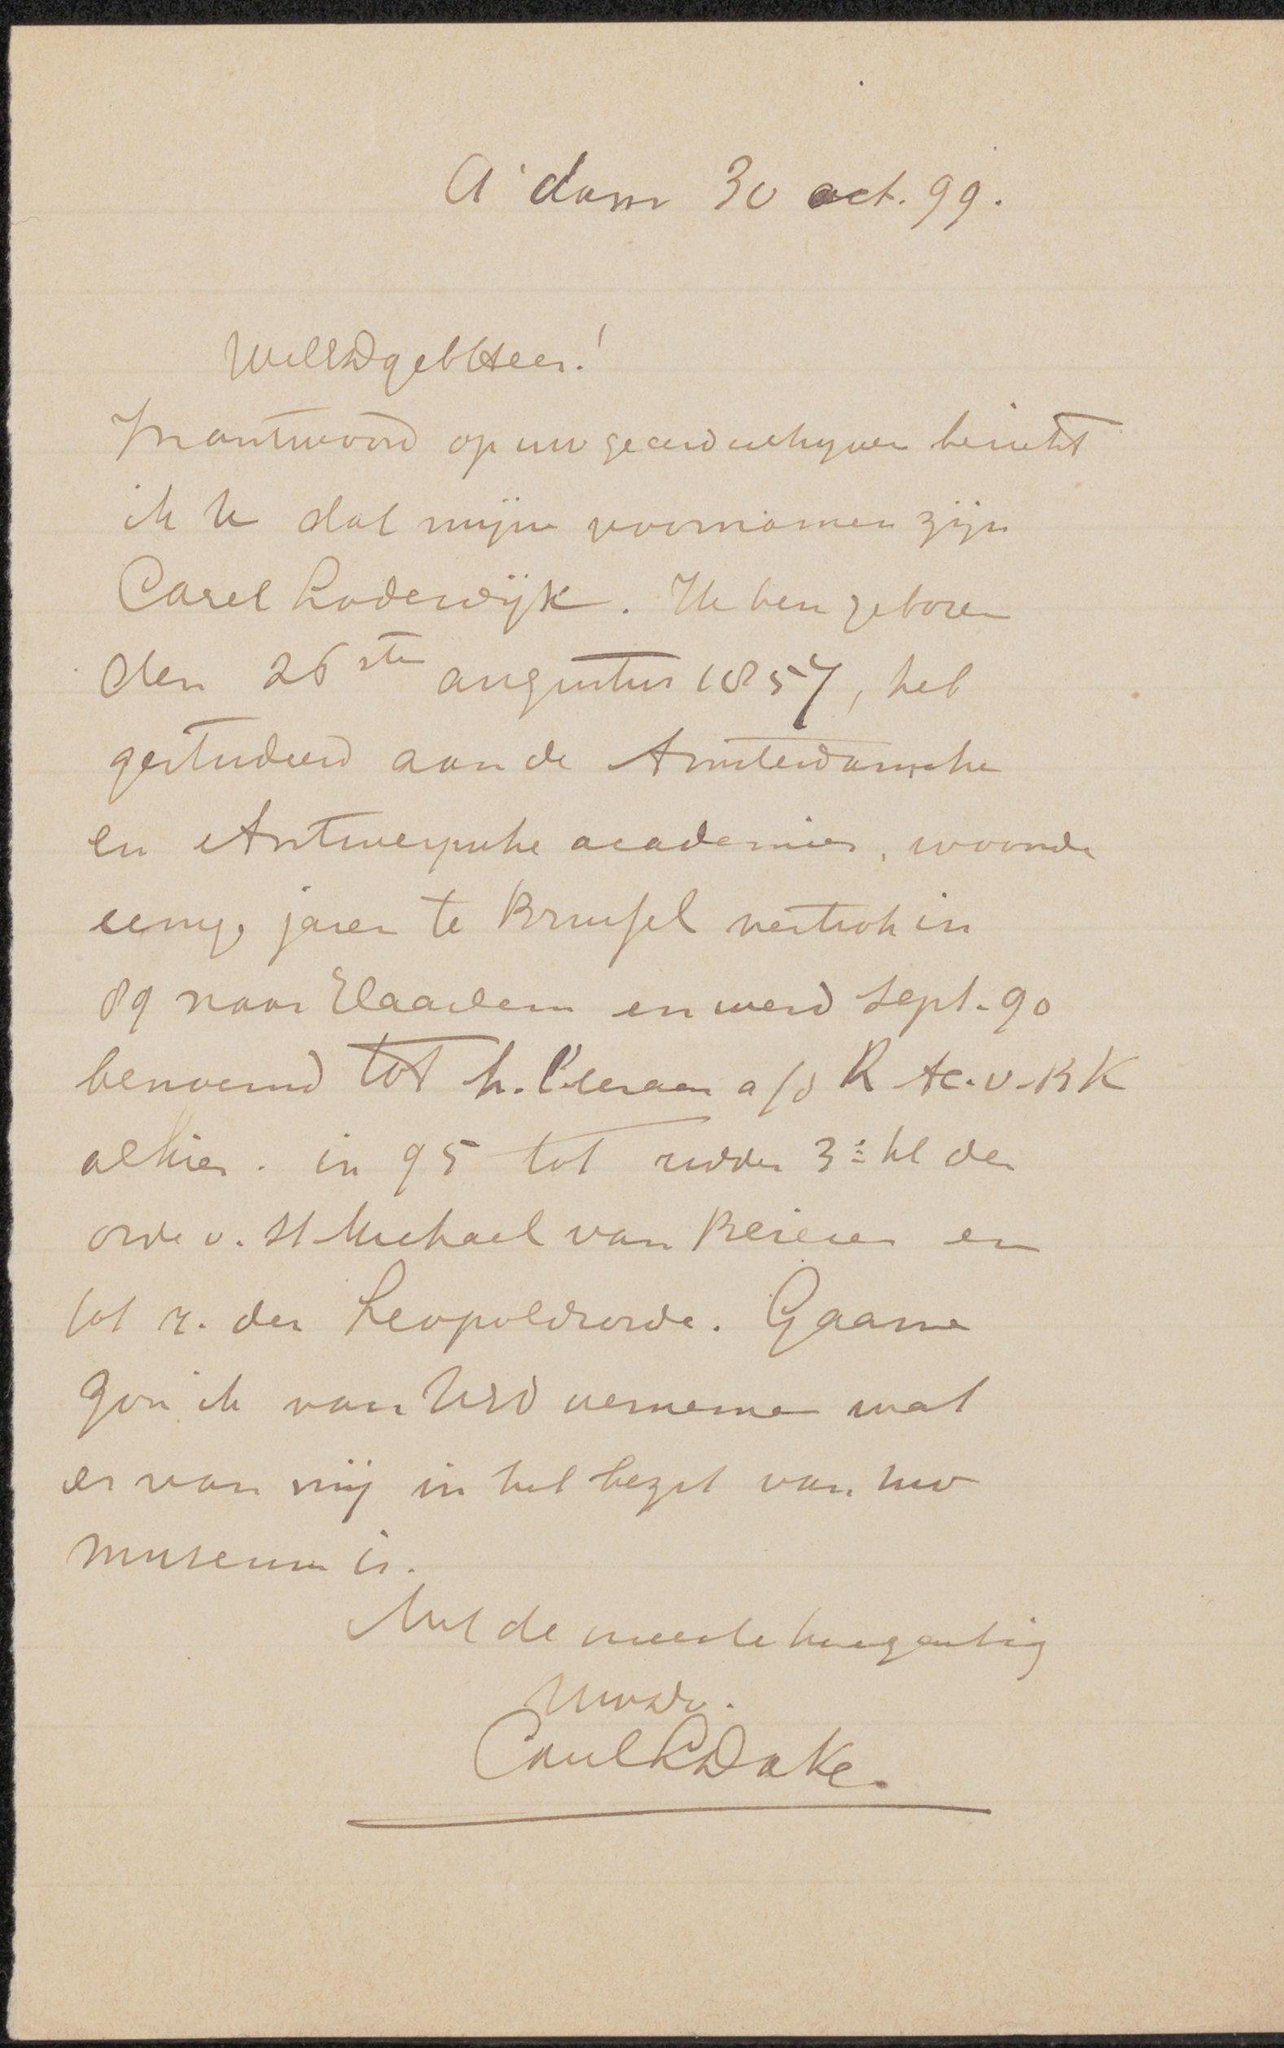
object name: letter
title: Brief aan Pieter Haverkorn van Rijsewijk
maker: carel lodewijk dake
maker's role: draughtsman, painter, print maker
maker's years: 1857-1918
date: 1899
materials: ink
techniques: pen, writing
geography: amsterdam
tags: pieter haverkorn van rijsewijk, education, tuition of the artist (in general), art collecting, haarlem, brussels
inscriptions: collector's mark: ‘RPK’